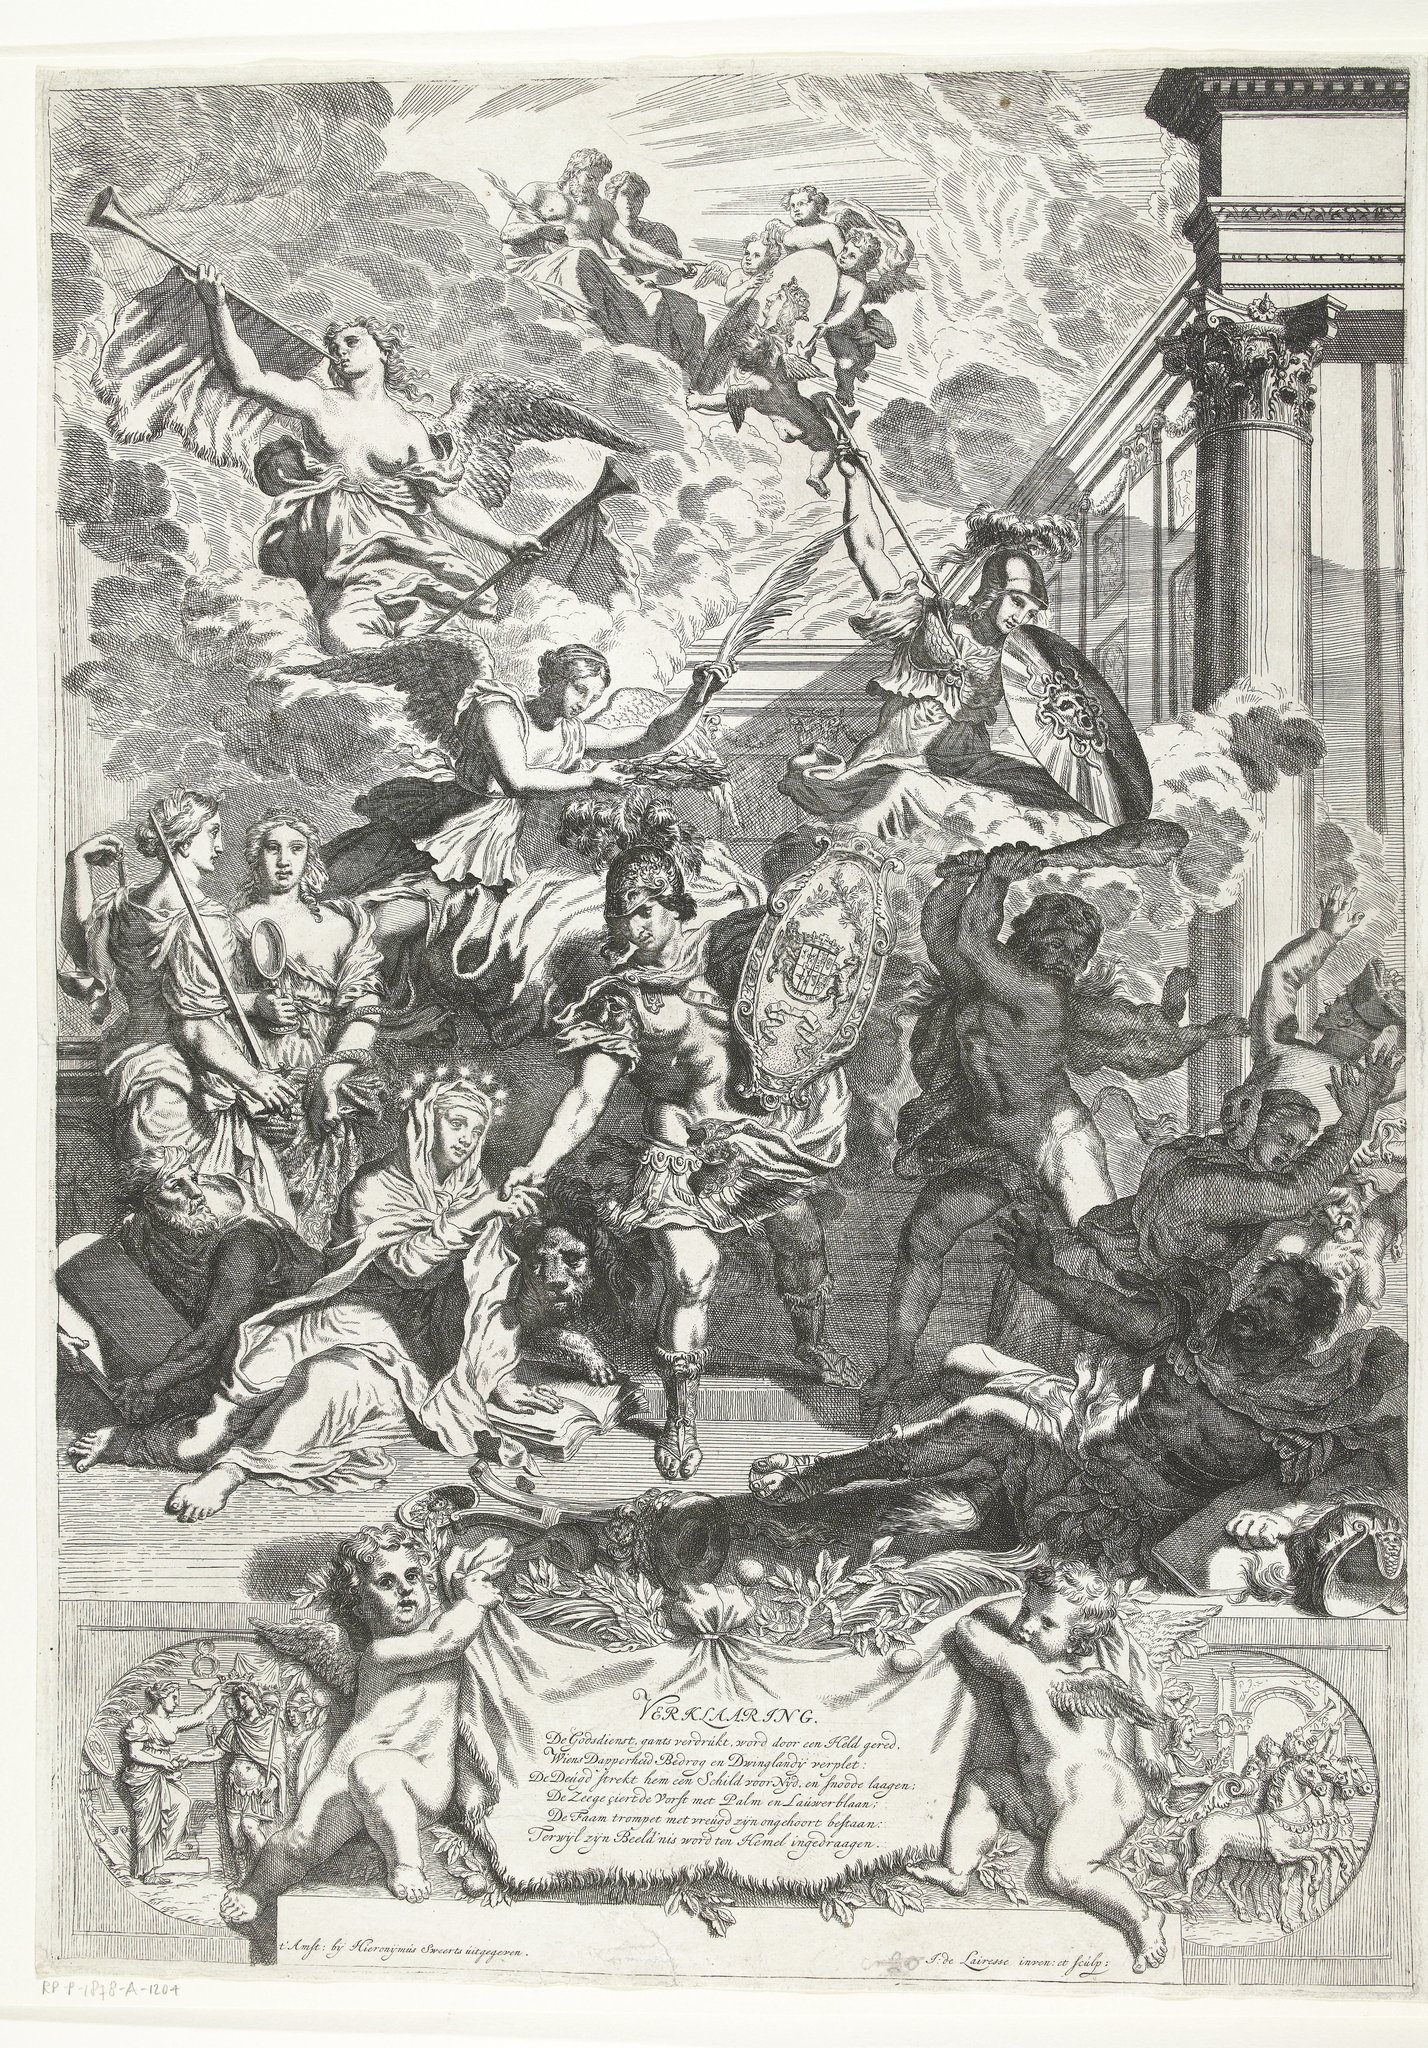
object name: print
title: Allegorie op het herstel van de Godsdienst in Engeland door Willem III, 1688-1689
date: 1688-1689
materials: paper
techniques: etching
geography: amsterdam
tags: the hague, william iii (prince of orange and king of england, scotland, and ireland), true religion vs. false religion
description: Allegorie op het herstel van de Godsdienst in Engeland door Willem III, 1688-1689. Als een Romeinse held redt Prins Willem (met Engels schild) de maagd van de Godsdienst (met zeven sterretjes als aureool), achter haar schuilt Mozes met de tafelen der wet. Hercules verjaagt met een knots Bedrog, Nijd en andere vijanden. Rondom verschillende personificaties die wijzen op de goedheid van de Prins. Op de voorgrond een vers opgehouden door twee engelen.